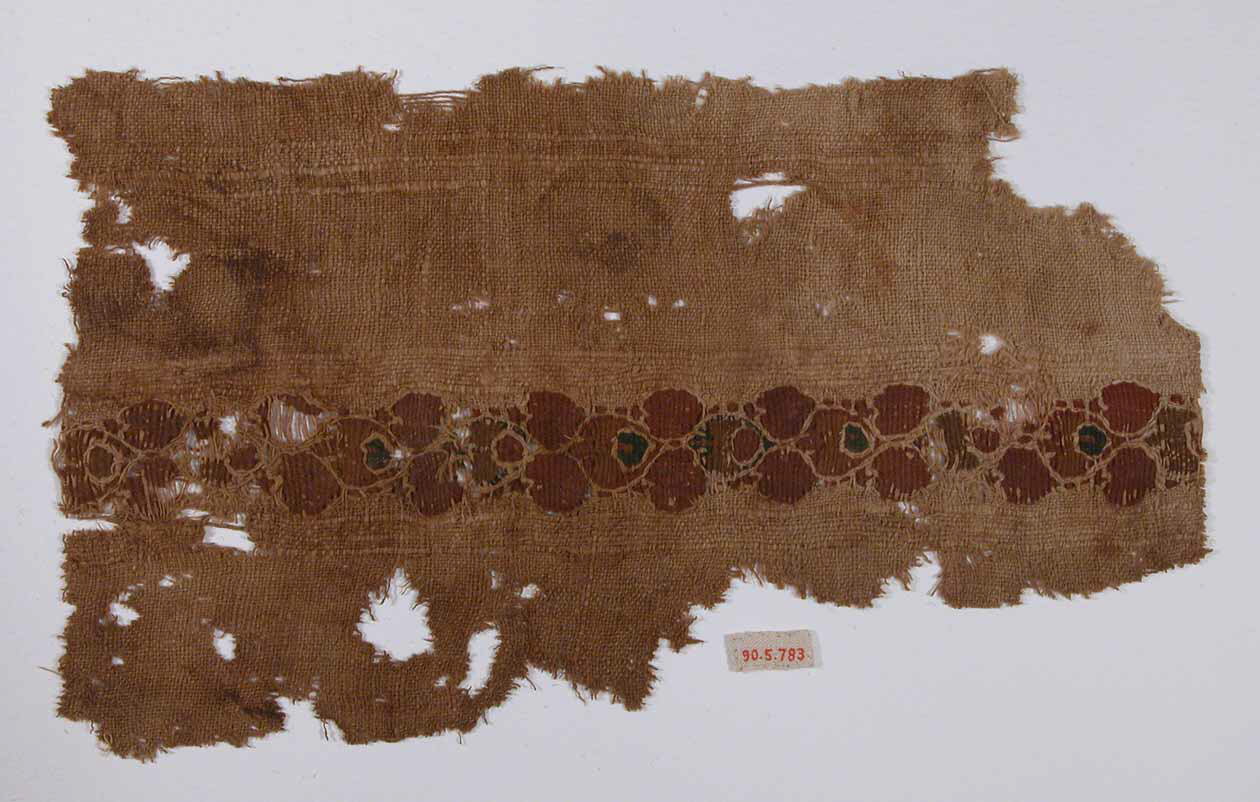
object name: textile fragment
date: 401-500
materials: linen, wool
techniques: weave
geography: egypt